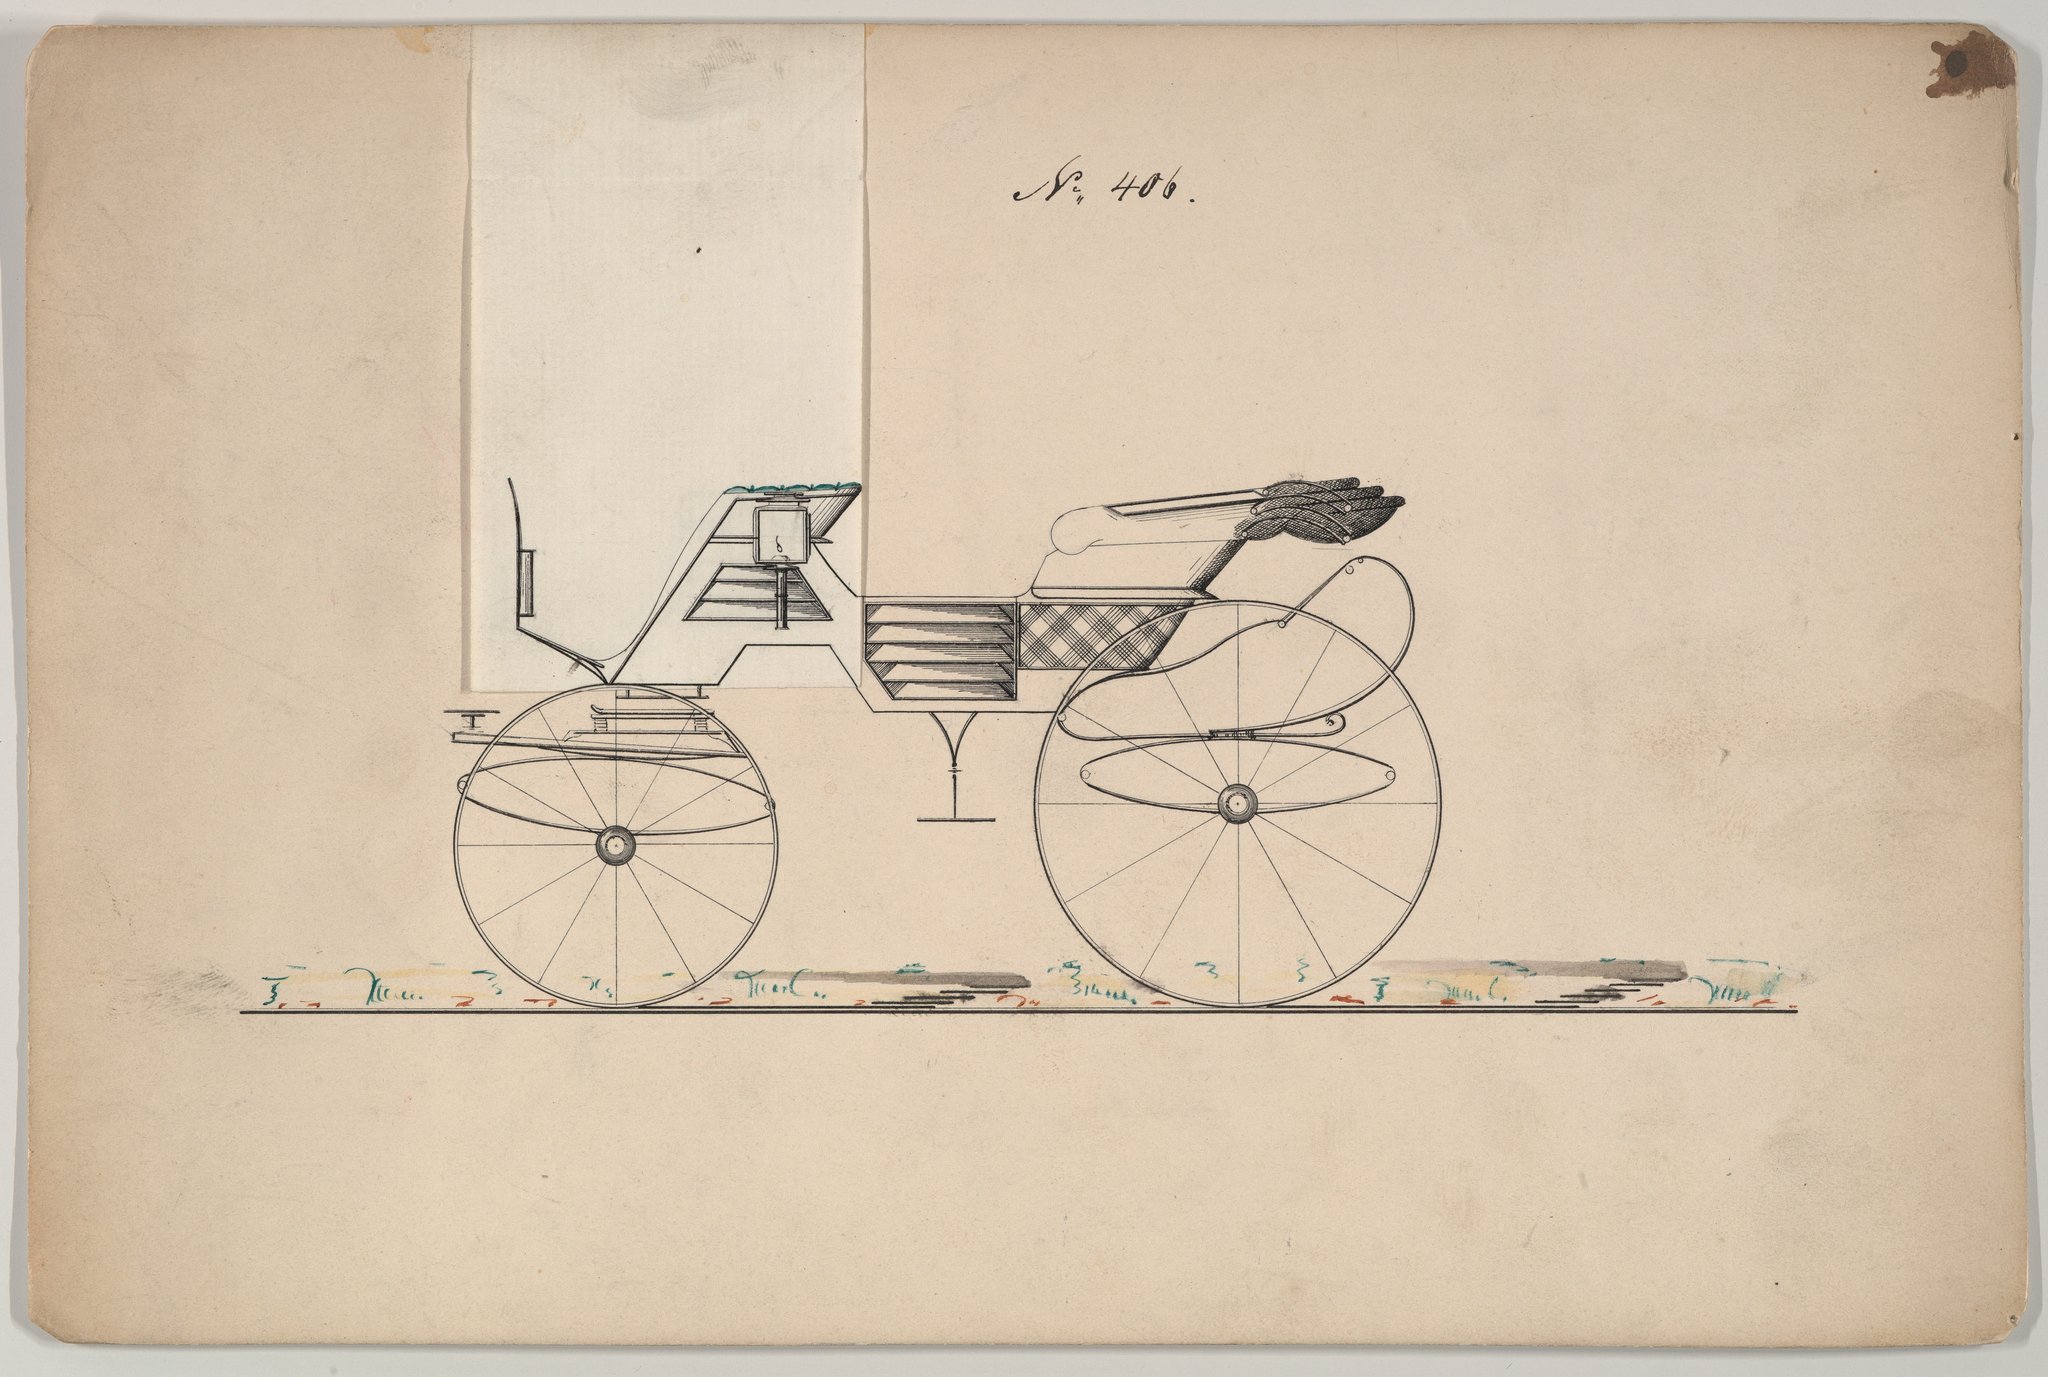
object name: drawing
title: Design for Phaeton, no. 406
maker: brewster & co.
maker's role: manufacturer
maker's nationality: american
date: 1850-1874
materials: gouache, ink, watercolor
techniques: pen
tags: carriages